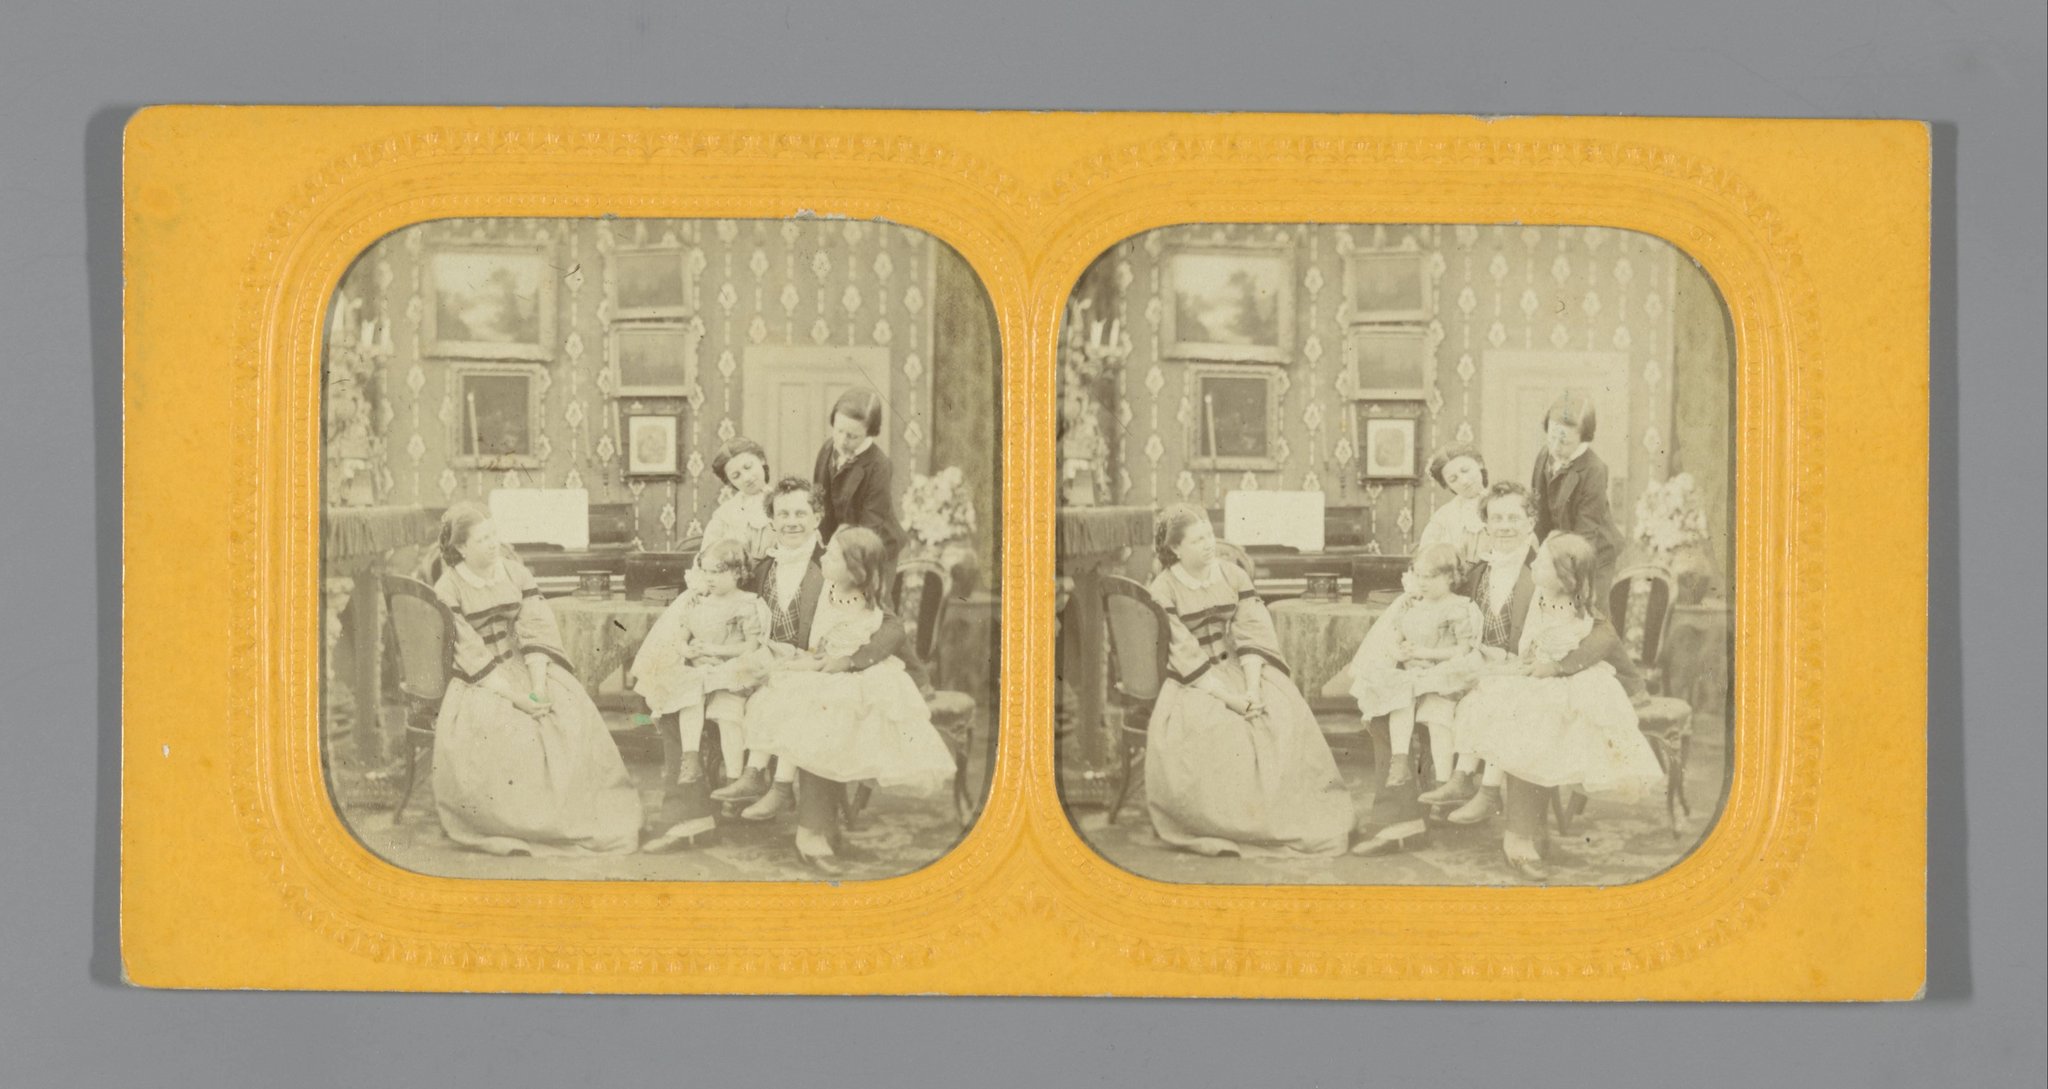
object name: tissue stereograph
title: Echtpaar met vier kinderen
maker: Anonymous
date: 1855-1875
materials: cardboard, paper, photographic support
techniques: albumen print, hand coloring, perforating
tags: family life at home